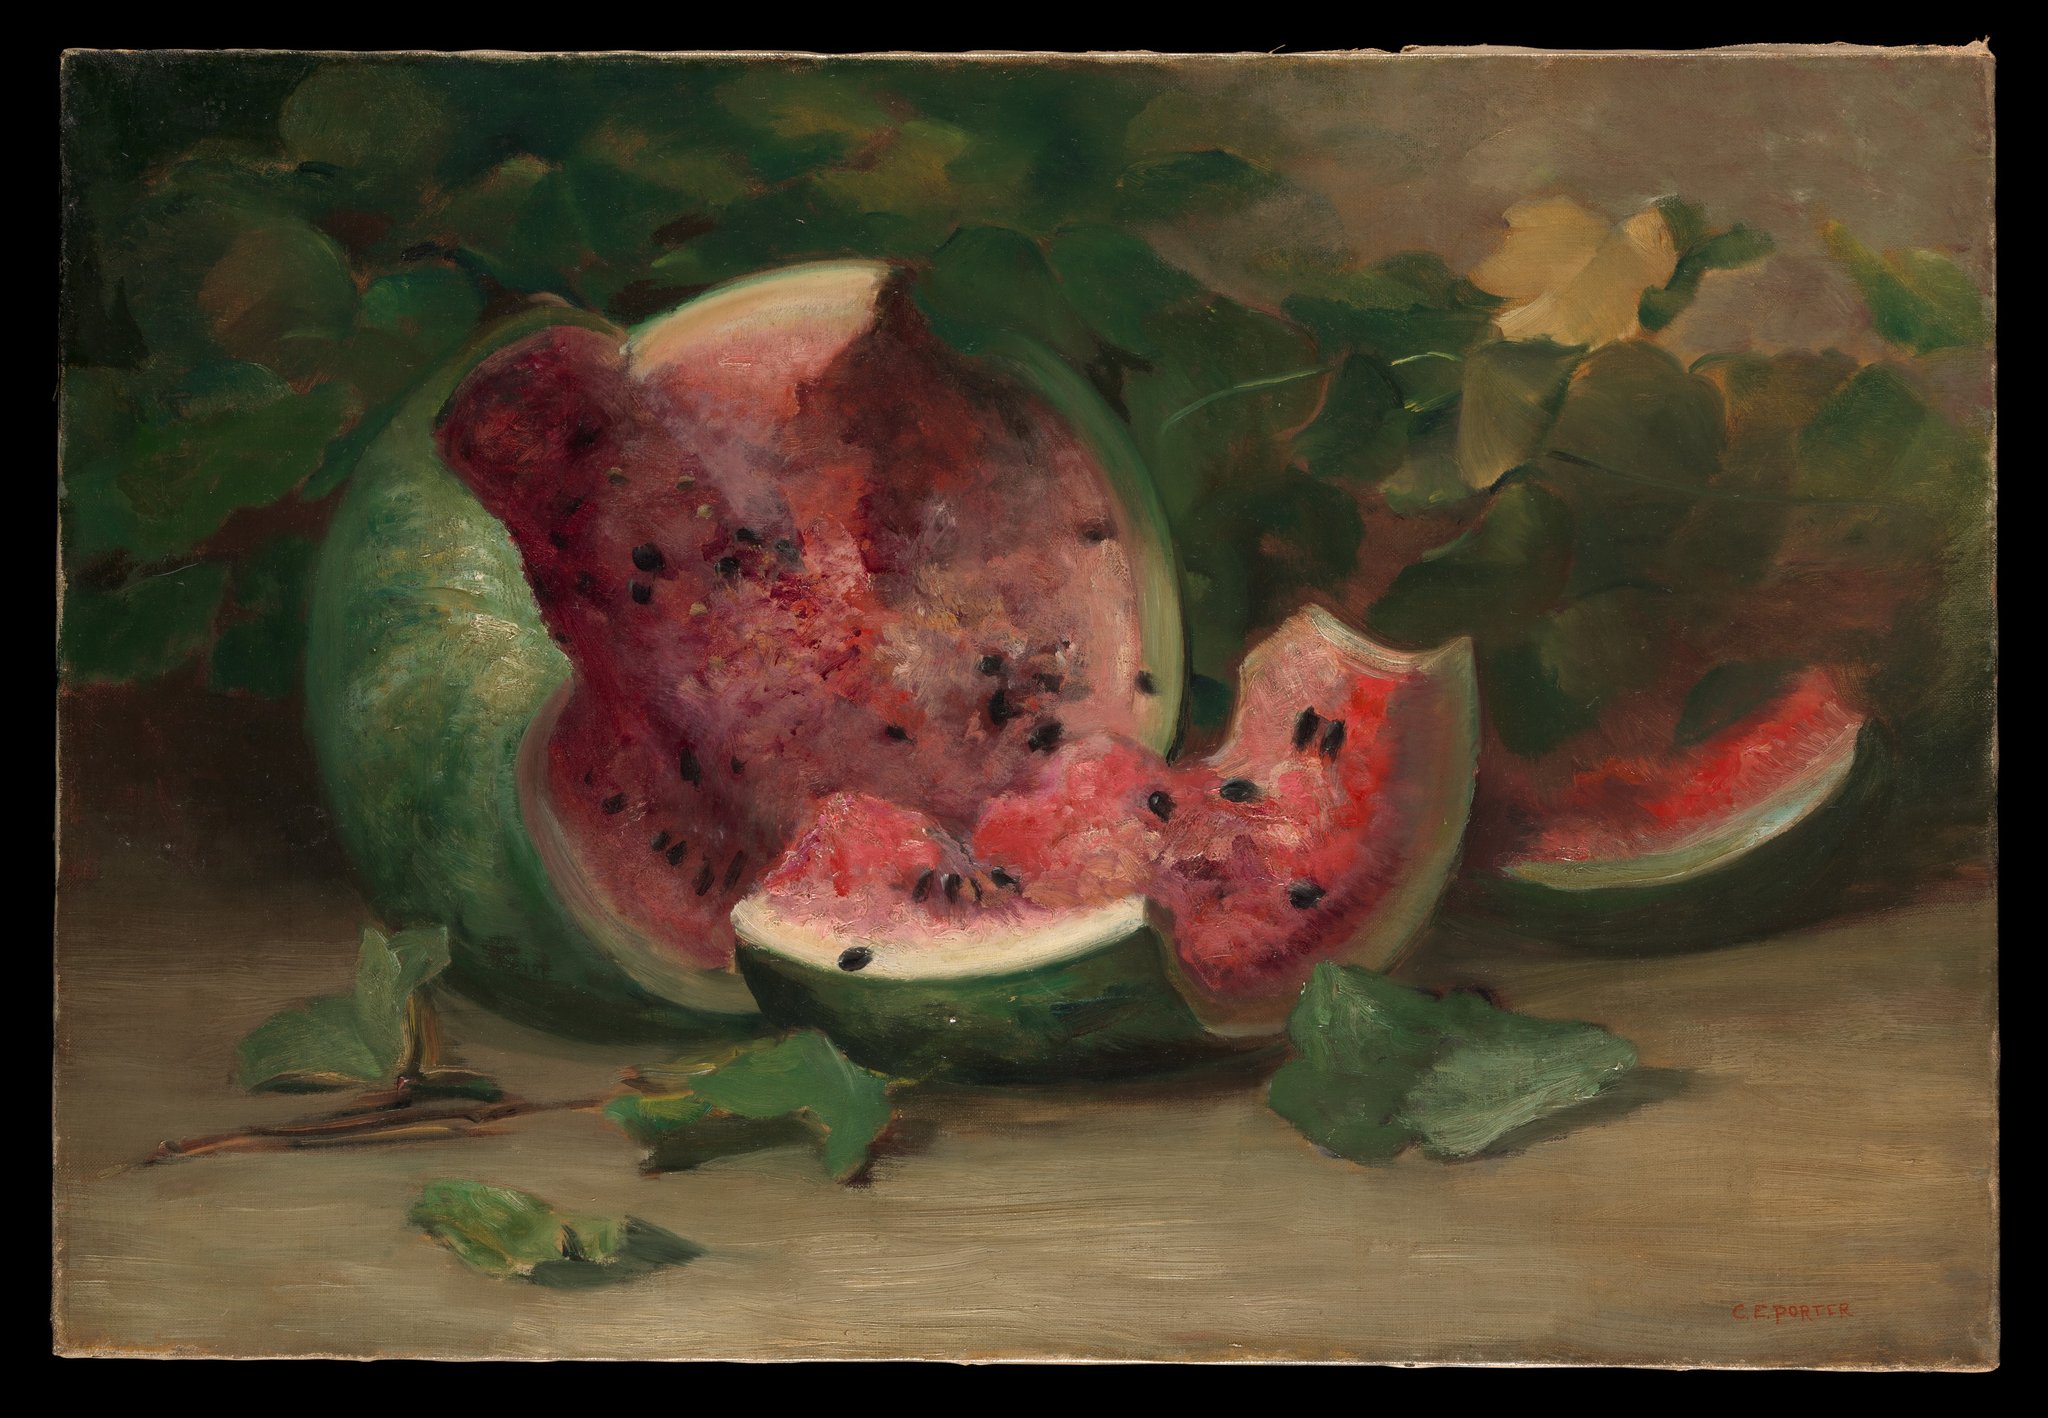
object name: painting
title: Untitled (Cracked Watermelon)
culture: american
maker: charles ethan porter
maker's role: artist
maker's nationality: american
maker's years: 1847-1923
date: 1890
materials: canvas, oil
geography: united states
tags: fruit,still life